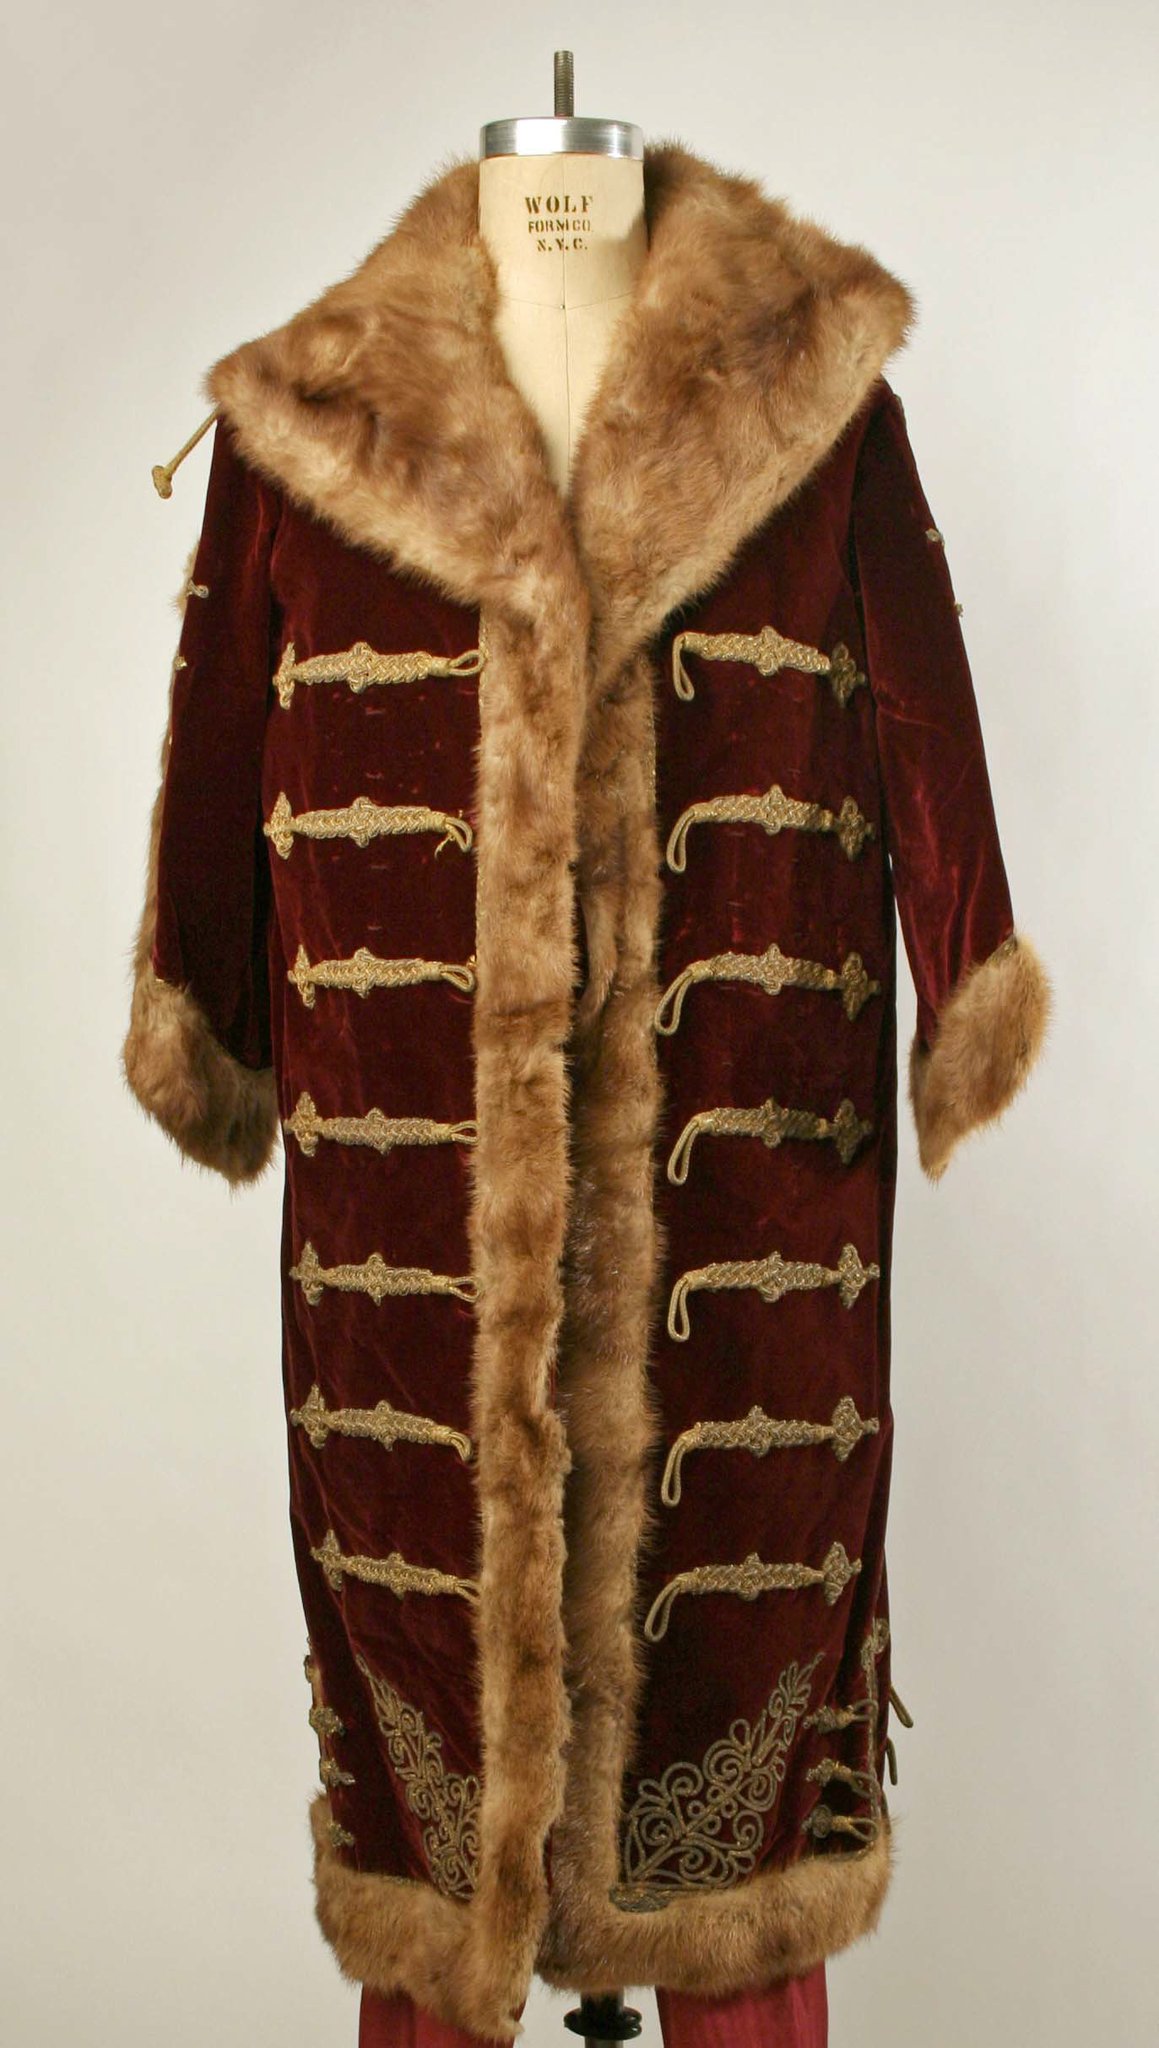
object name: costume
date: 1850-1900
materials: cotton, fur, leather, linen, metal thread, silk, wool